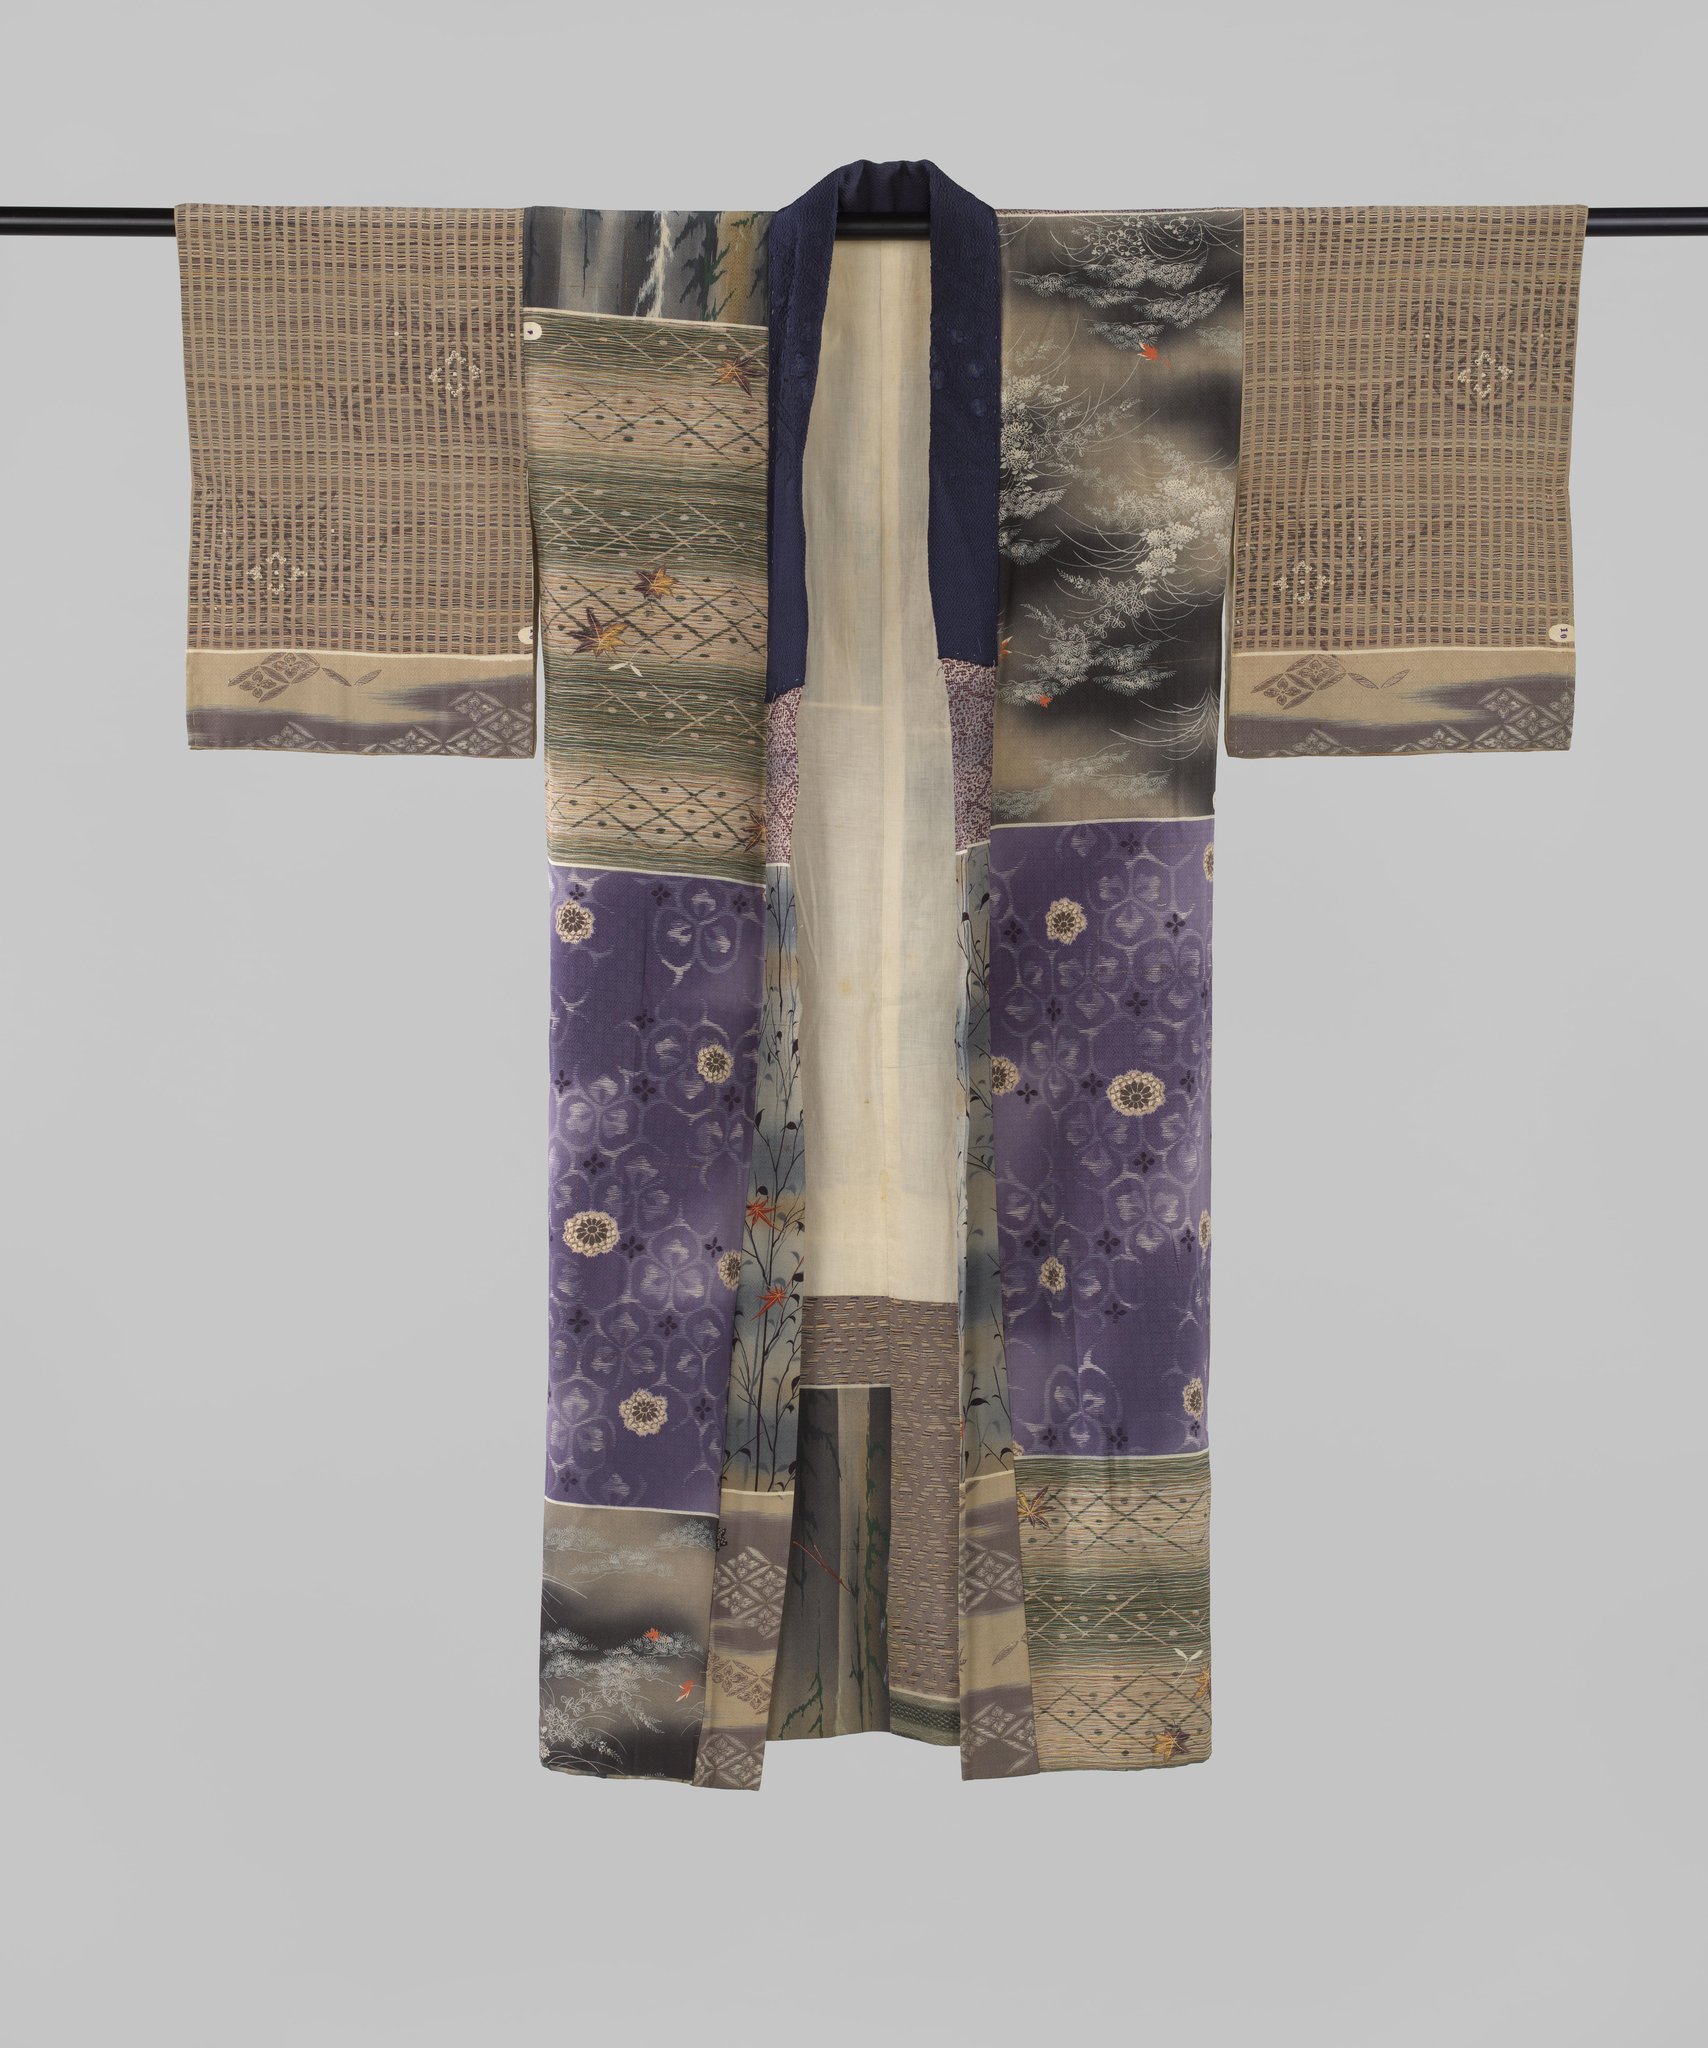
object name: kimono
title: Vrouwen onderkimono met herfstpatronen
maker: Anonymous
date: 1920-1940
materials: silk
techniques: painting, weave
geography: japan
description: Onderkimono (nagajuban) voor een vrouw met versiering van elf verschillende patronen met herfstmotieven in rechthoekige vlakken. Fijne crêpe zijde (kinsha) met een damast geweven bloempatroon, met gestencilde yuzen versiering en goudfolie. Voering van katoen.